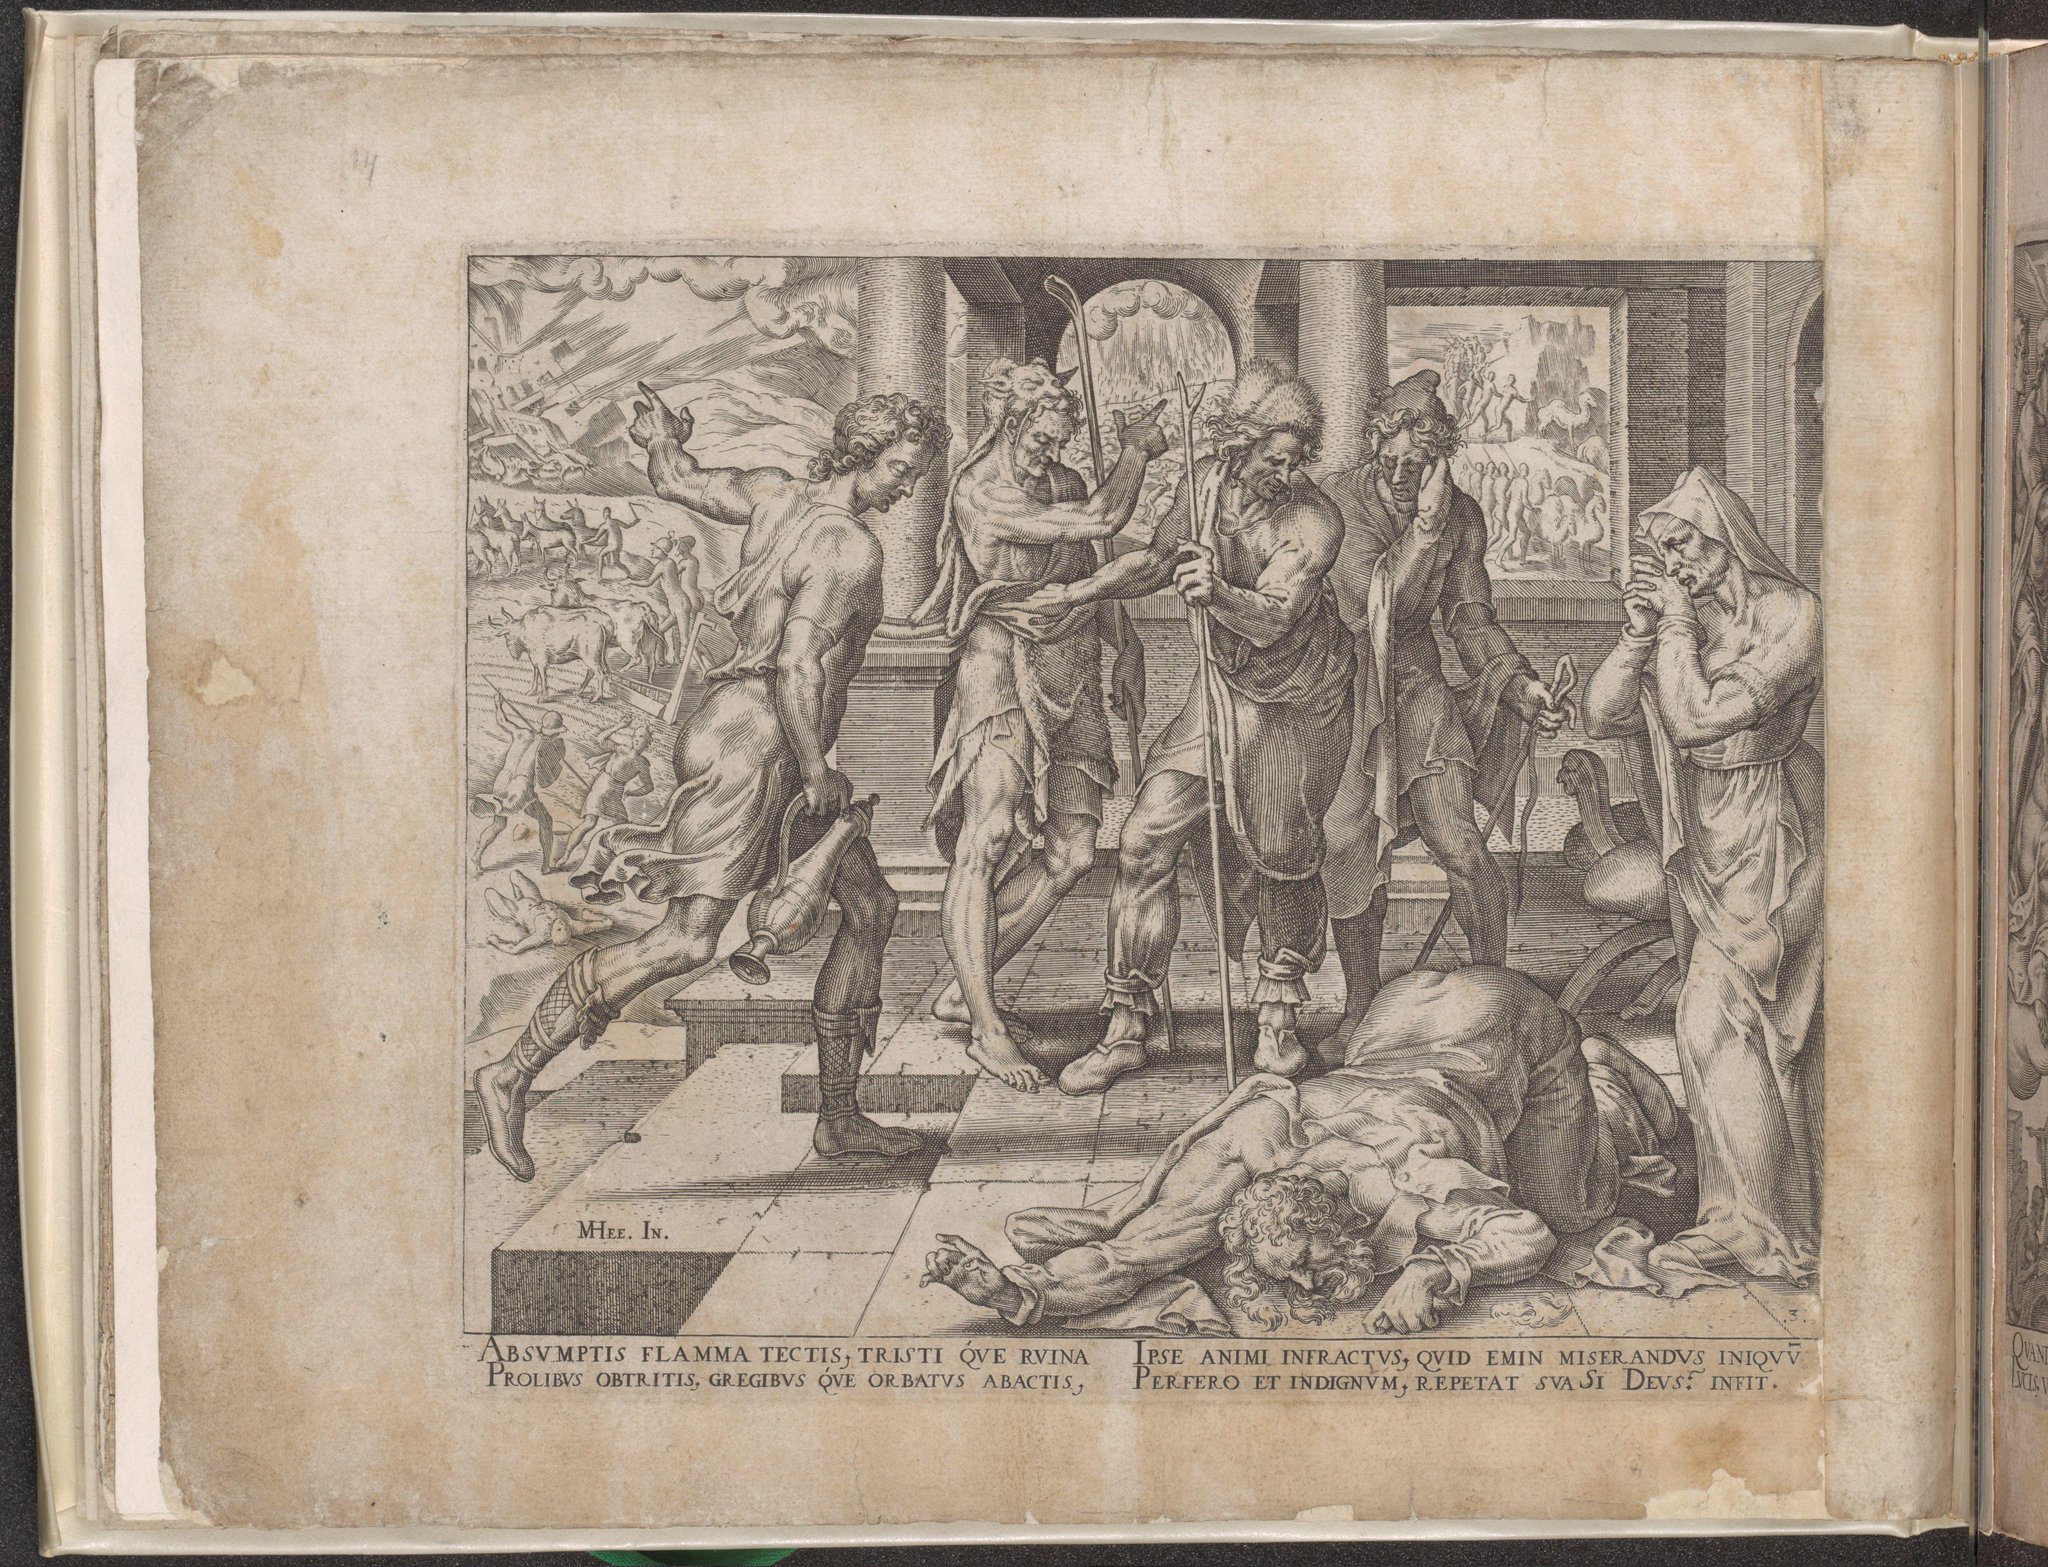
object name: album leaf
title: Geschiedenis van Job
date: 1563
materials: paper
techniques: engraving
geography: haarlem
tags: messengers present themselves to job, each reporting a new disaster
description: Job hoort van vier boodschappers over het onheil dat hem is overkomen. In het landschap is te zien hoe Jobs vee en kamelen worden gestolen, hoe zijn herders en vee zijn omgekomen door de bliksem en hoe het huis in de stad links, waarin de kinderen van Job een feest hielden, instort in de storm. Nadat Job het slechte nieuws heeft gehoord verscheurt hij zijn kleren en valt hij neer op de grond. Onder de voorstelling een verklarende tekst in het Latijn. Deze prent maakt deel uit van een album.